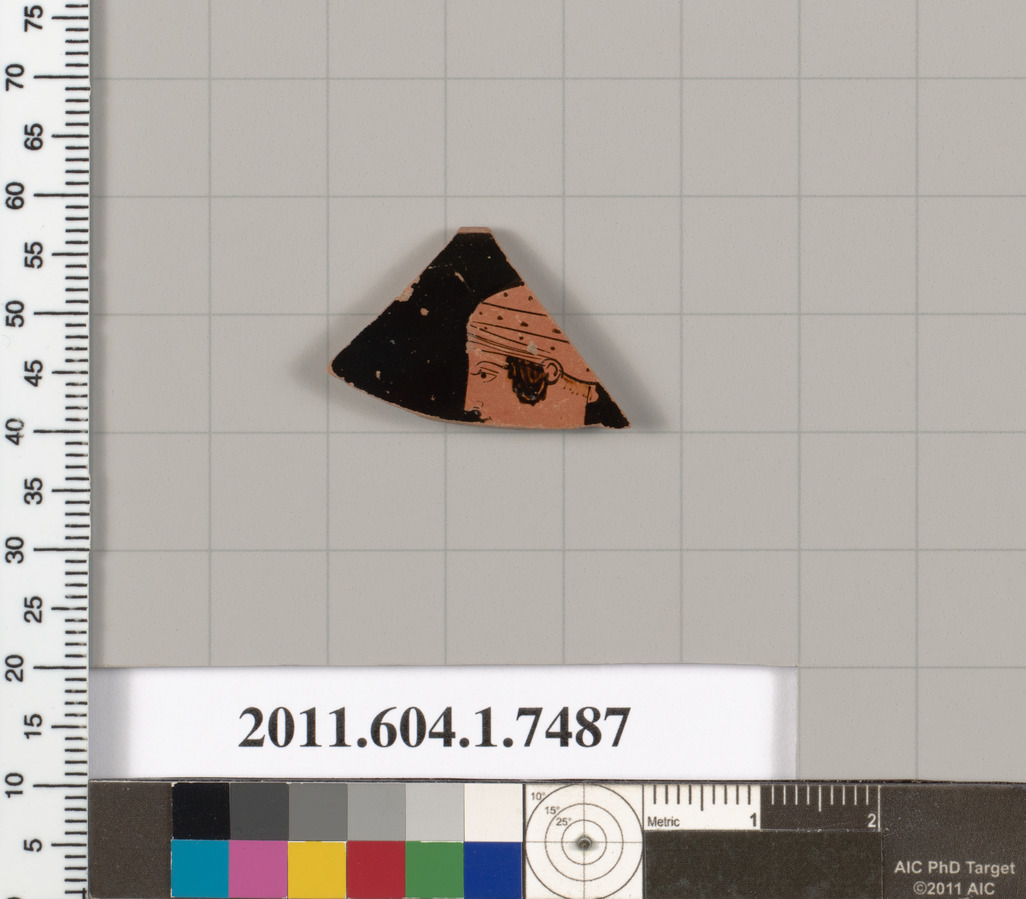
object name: kylix fragment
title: Terracotta rim fragment of a kylix (drinking cup)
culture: greek, attic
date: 460-450 BCE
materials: terracotta